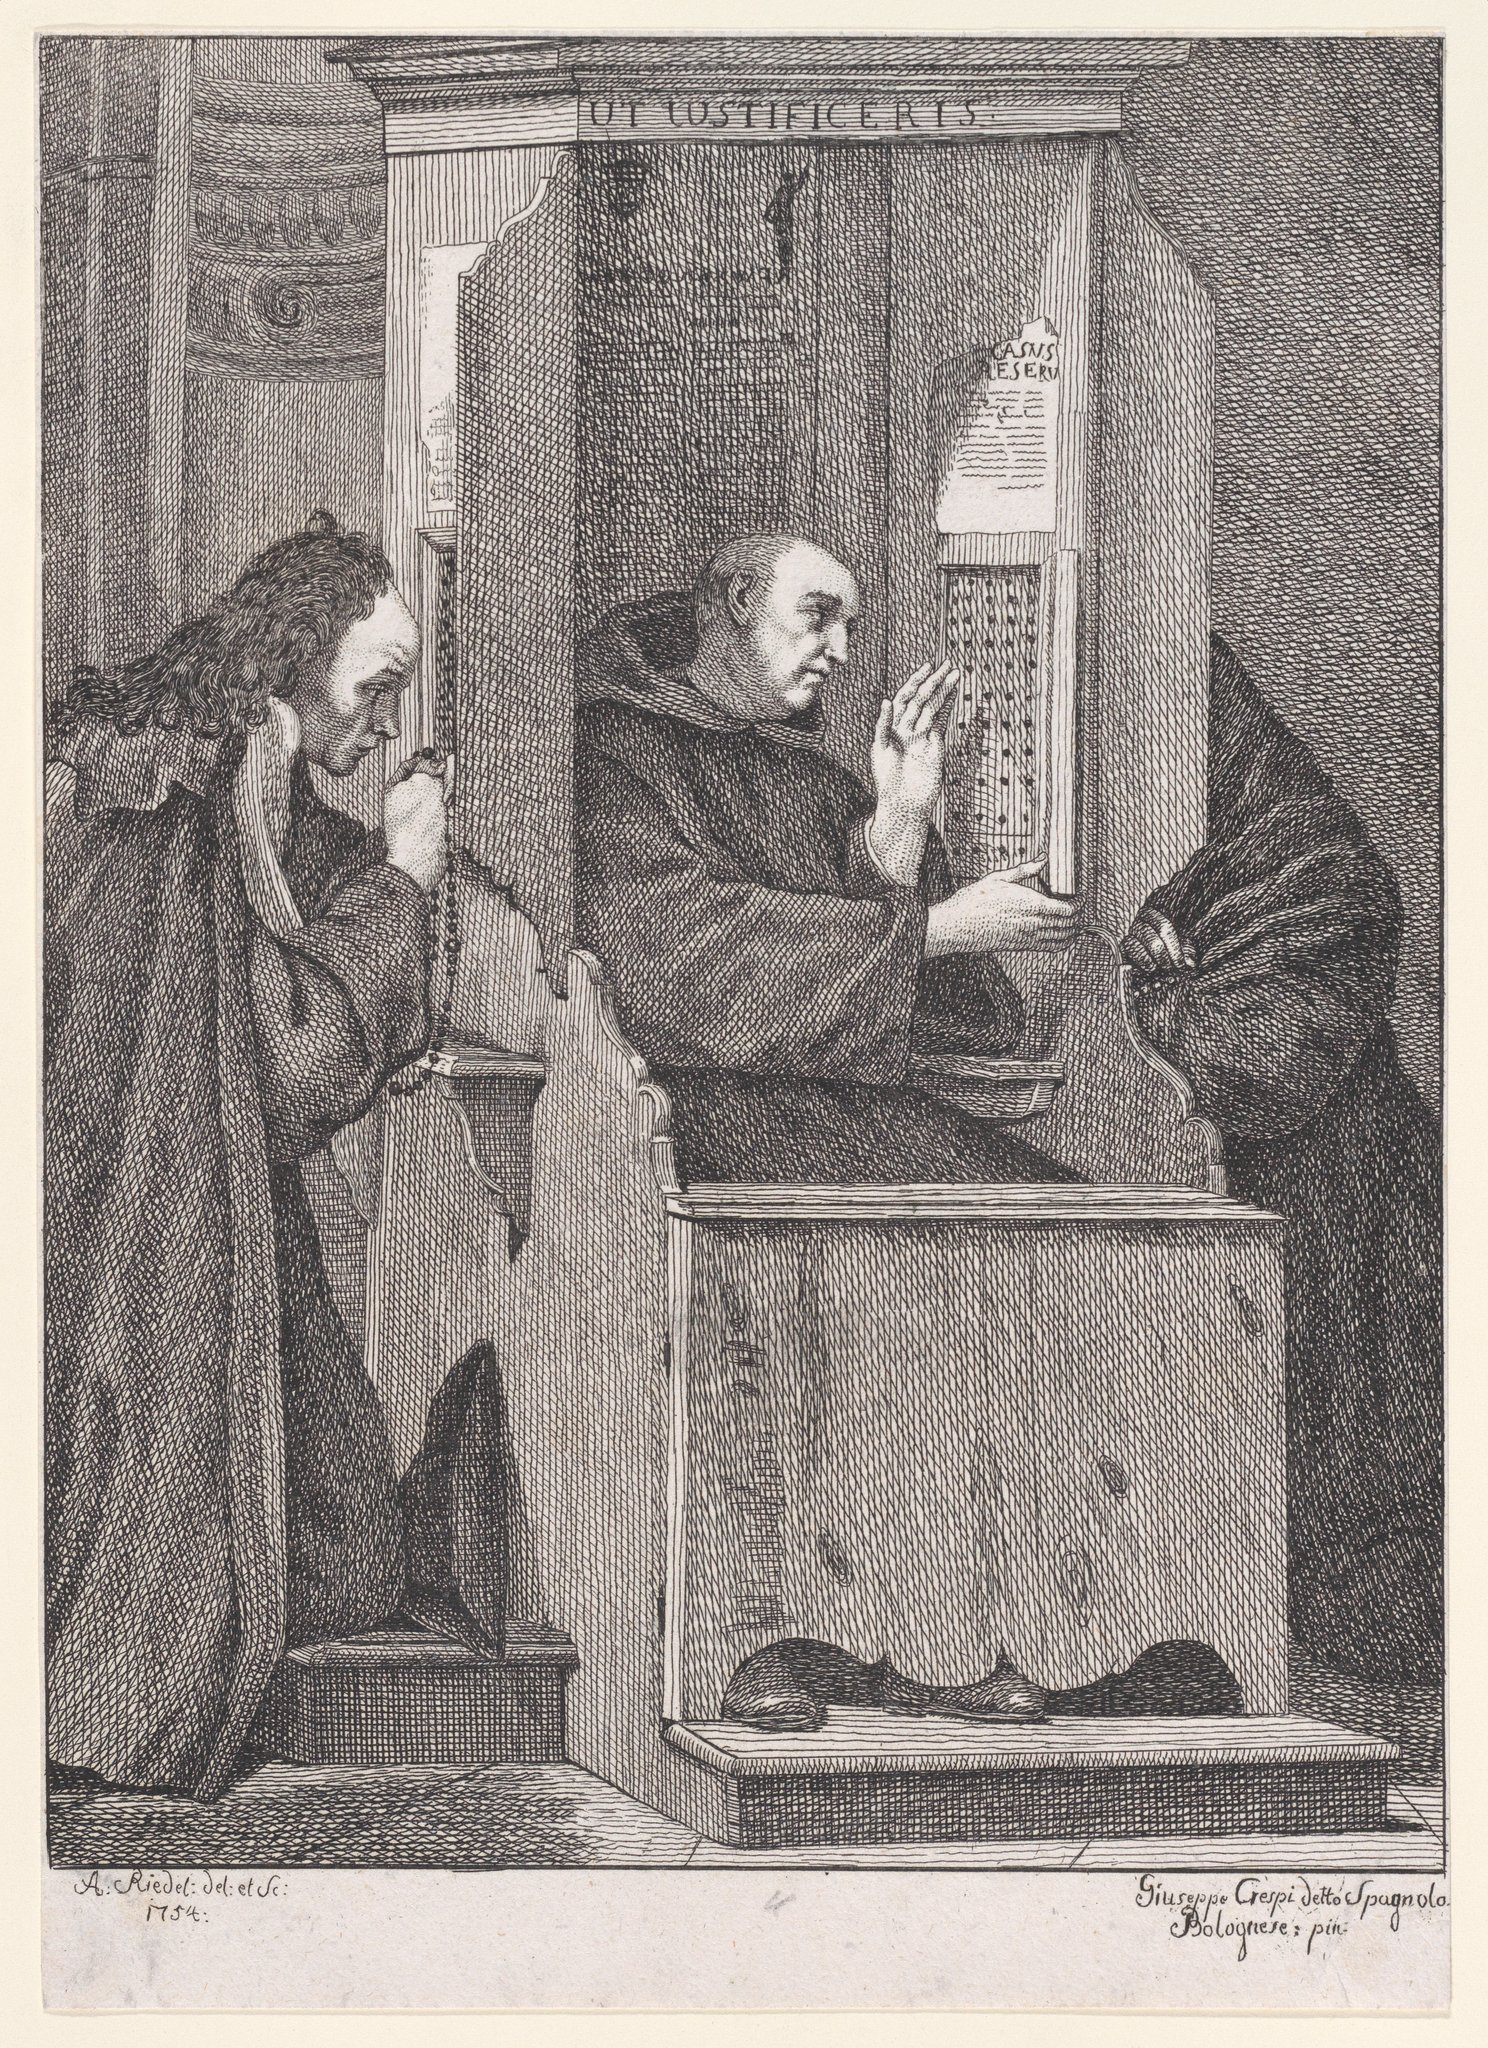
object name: print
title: Confession, from "The Seven Sacraments"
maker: johann anton riedel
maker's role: artist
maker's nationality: swiss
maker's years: 1736-1816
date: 1754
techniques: etching